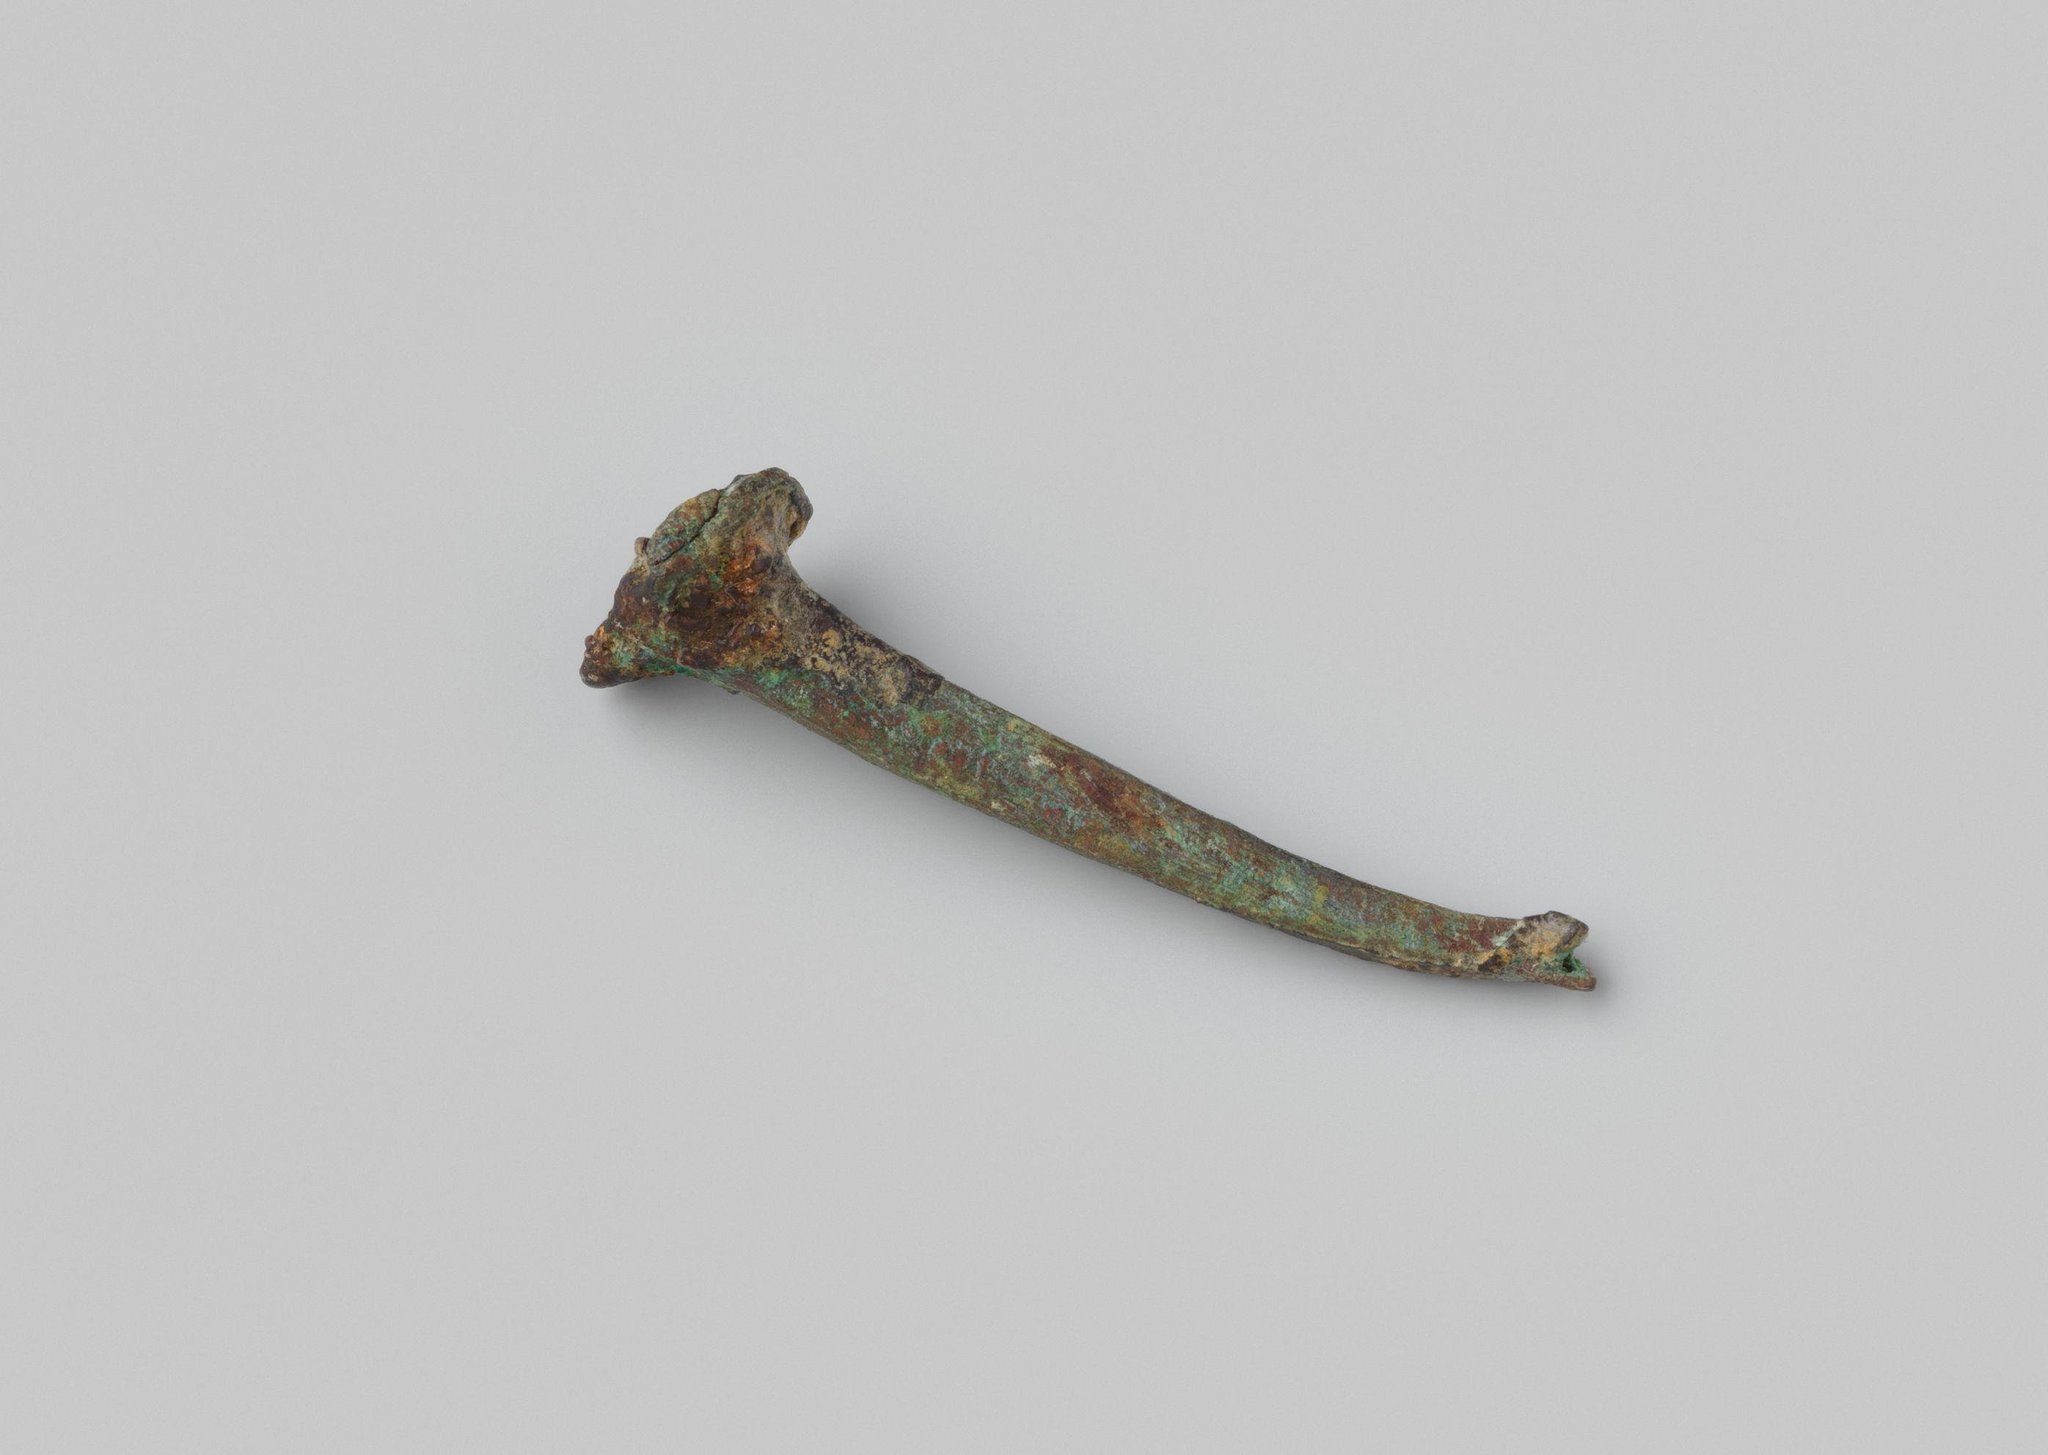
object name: nagel, spijker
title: Spijker afkomstig uit het wrak van de Oost-Indiëvaarder Hollandia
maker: Anonymous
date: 1700-1743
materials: iron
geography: netherlands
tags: verenigde oostindische compagnie, hollandia (schip)